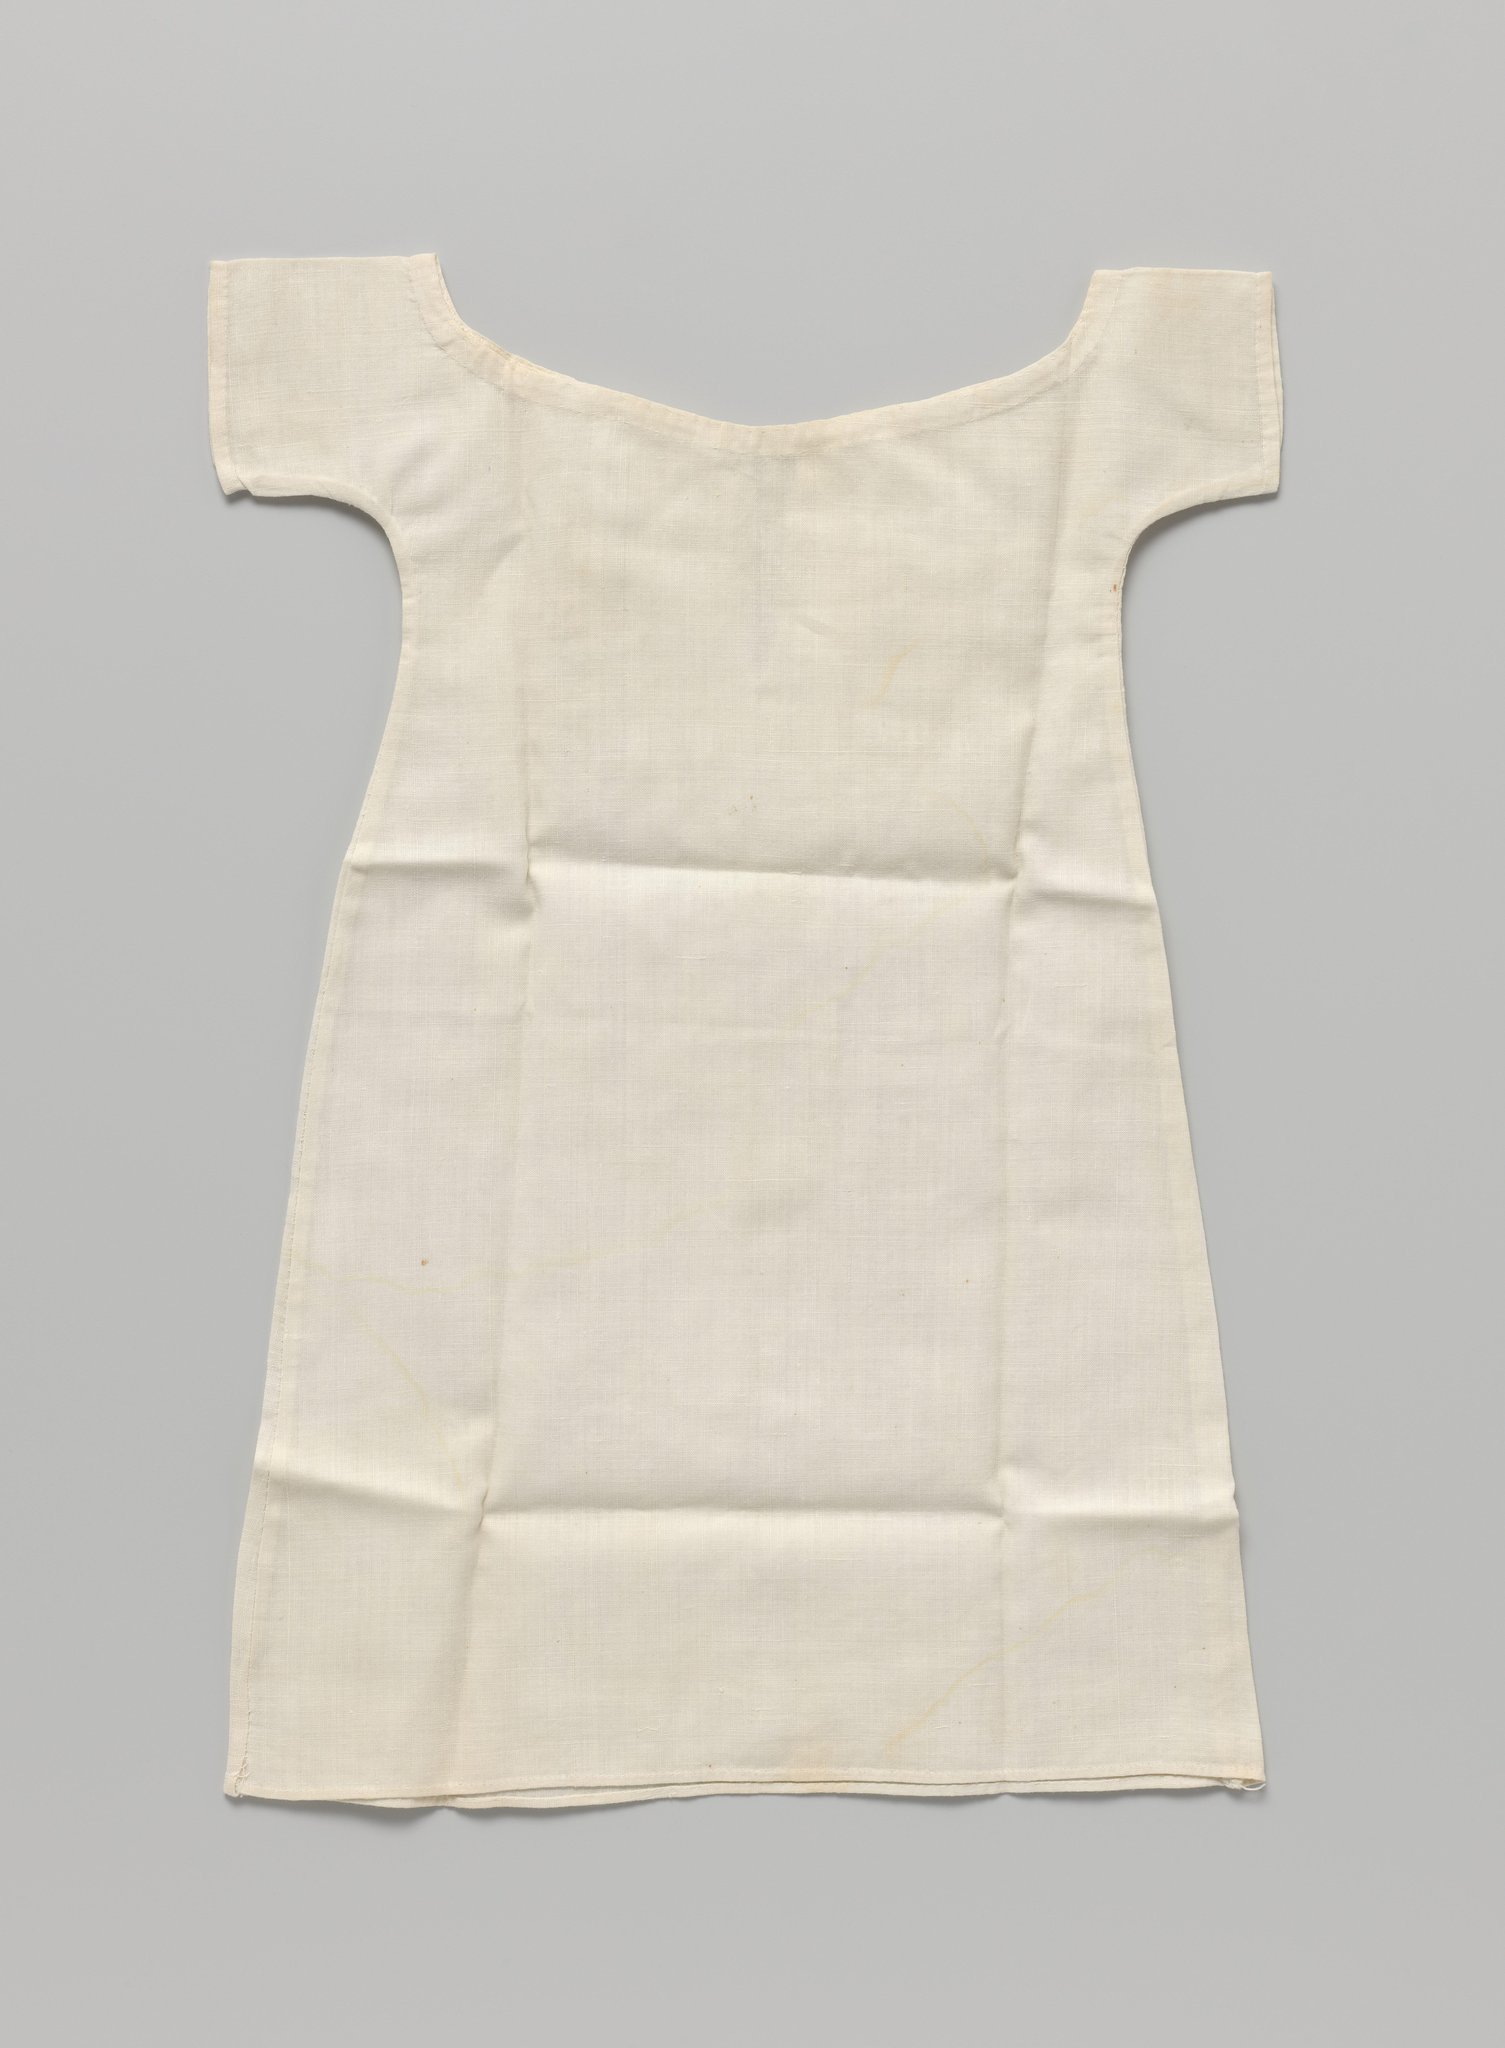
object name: doll's clothing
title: Effen witte jurk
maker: Anonymous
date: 1850-1920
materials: textile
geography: netherlands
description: Op de voorzijde aan de rechterzijde een gerepareerd gat.